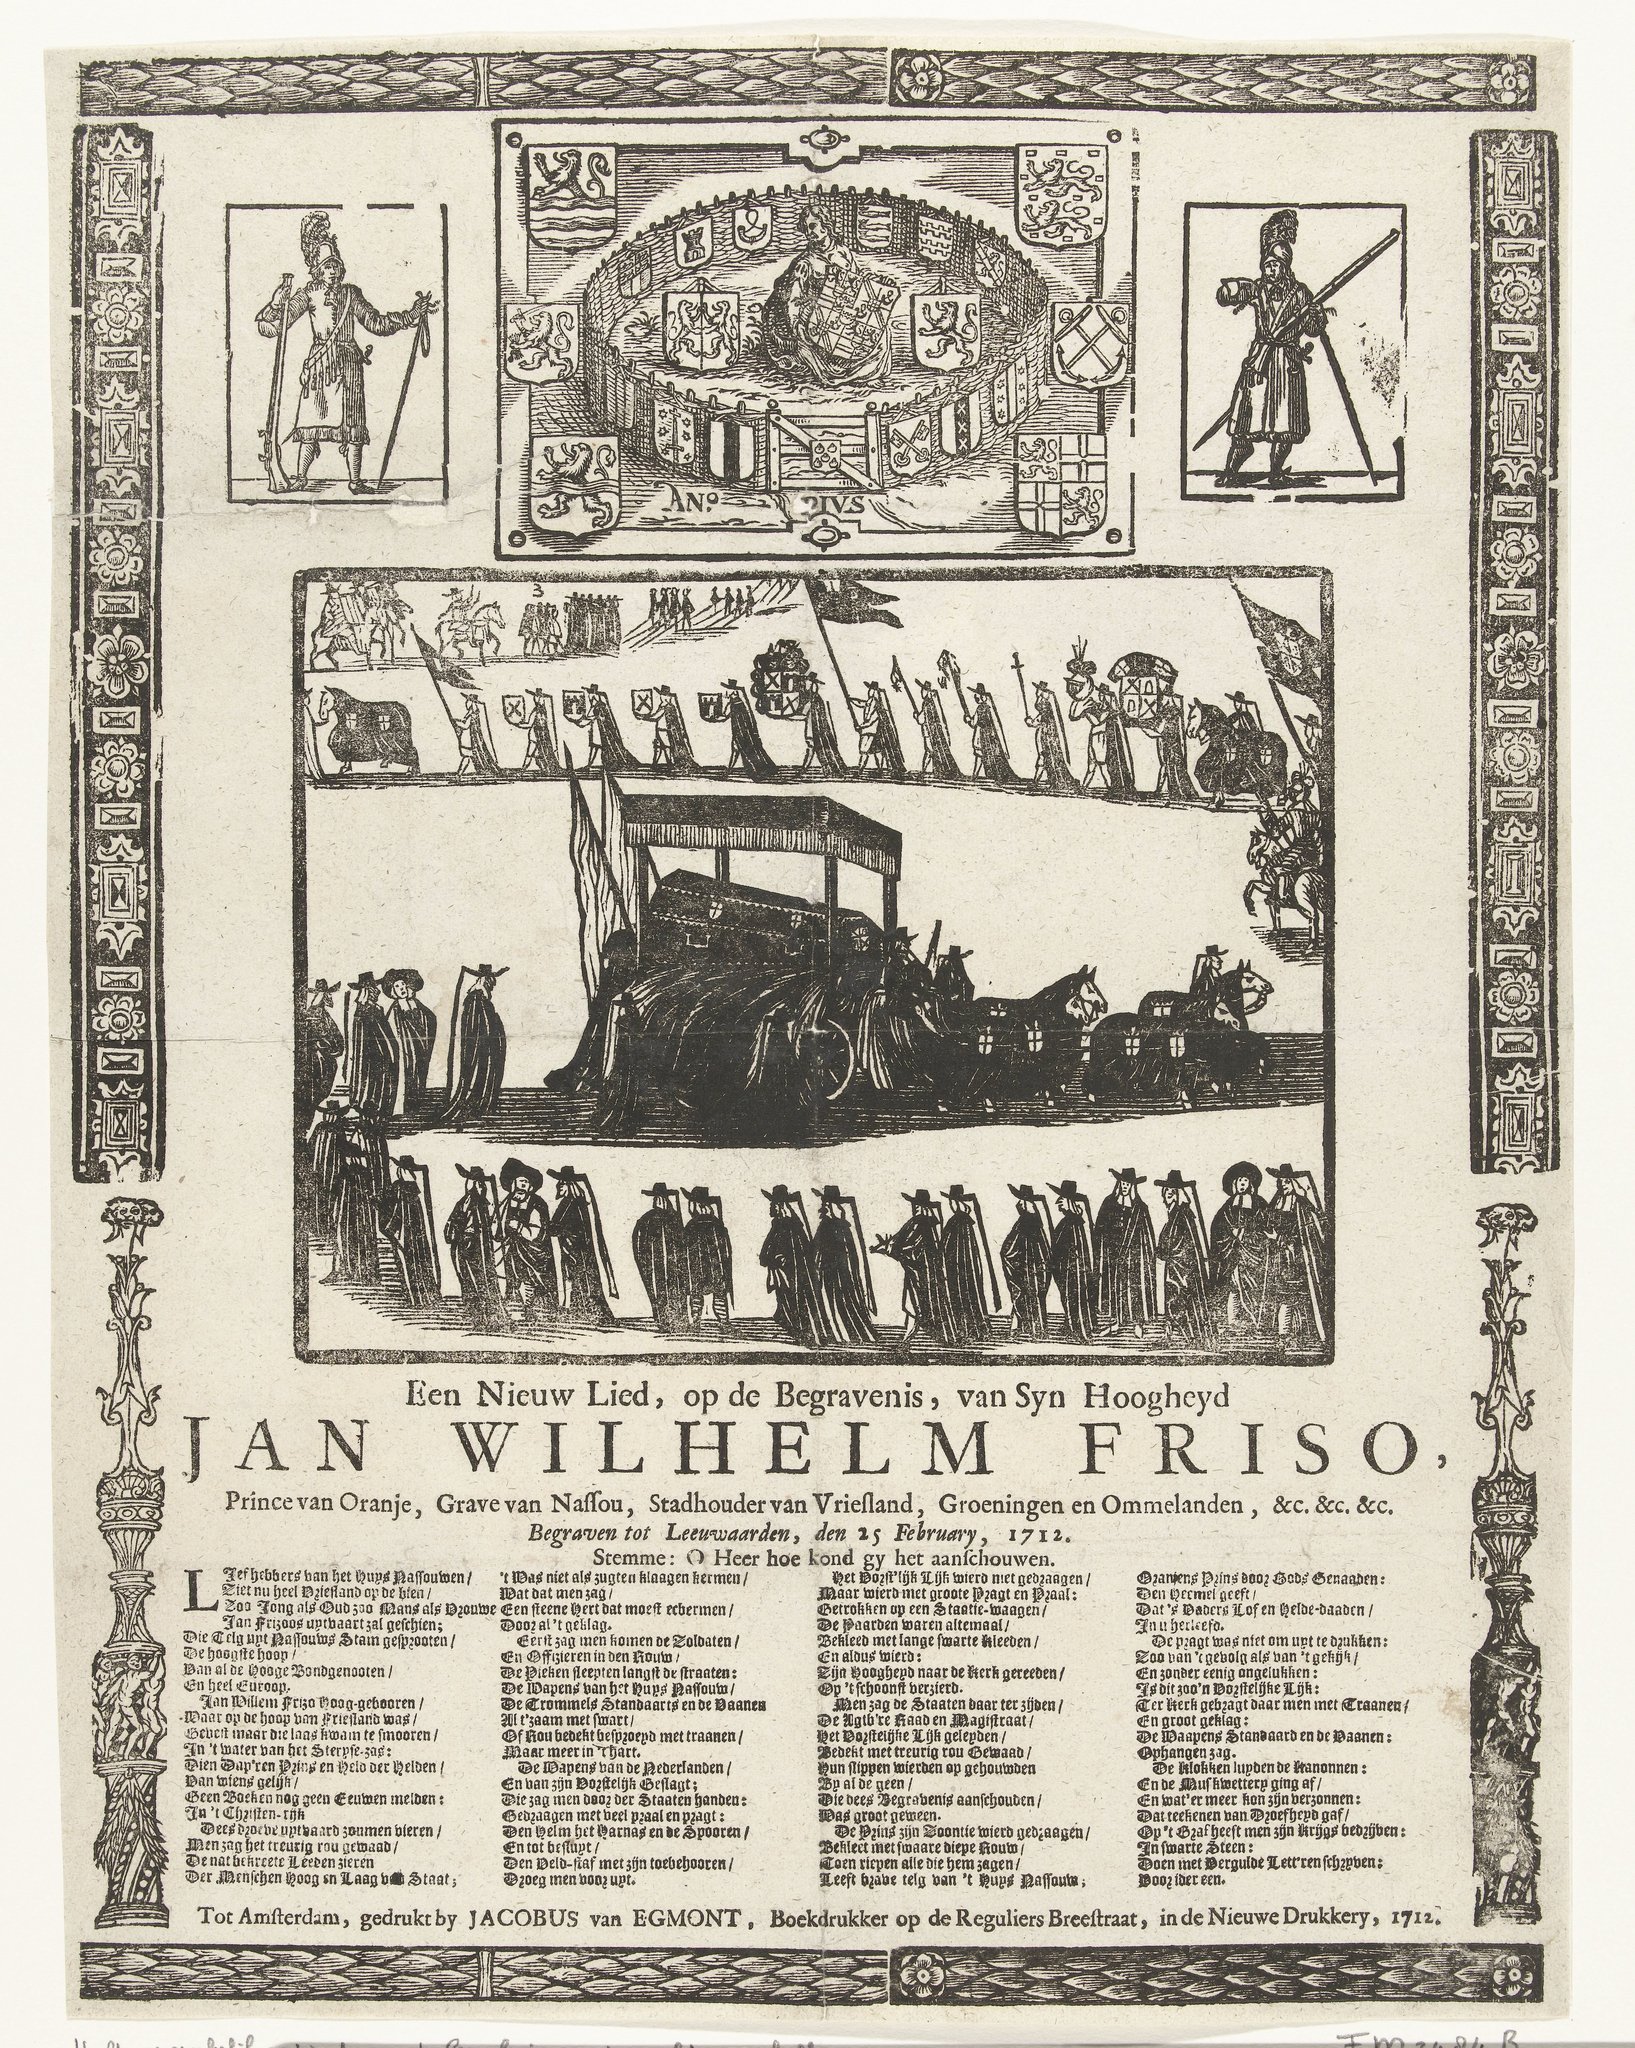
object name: print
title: Een Nieuw Lied, op de Begravenis, van Syn Hoogheyd Jan Wilhelm Friso (...) Begraven tot Leeuwaarden, den 25 February, 1712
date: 1712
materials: paper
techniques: letterpress printing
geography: amsterdam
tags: johan willem friso (prins van oranje-nassau), fenced or walled garden; 'hortus conclusus', cortege, funeral procession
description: Begrafenis van prins Johan Willem Friso te Leeuwarden op 25 februari 1712. Centraal de begrafenisstoet in vier rijen, daarboven blokken van twee krijgslieden aan weerszijden van een blok van de Hollandse Tuin met de provinciewapens. Onderaan een lied op de overleden prins in 4 kolommen.